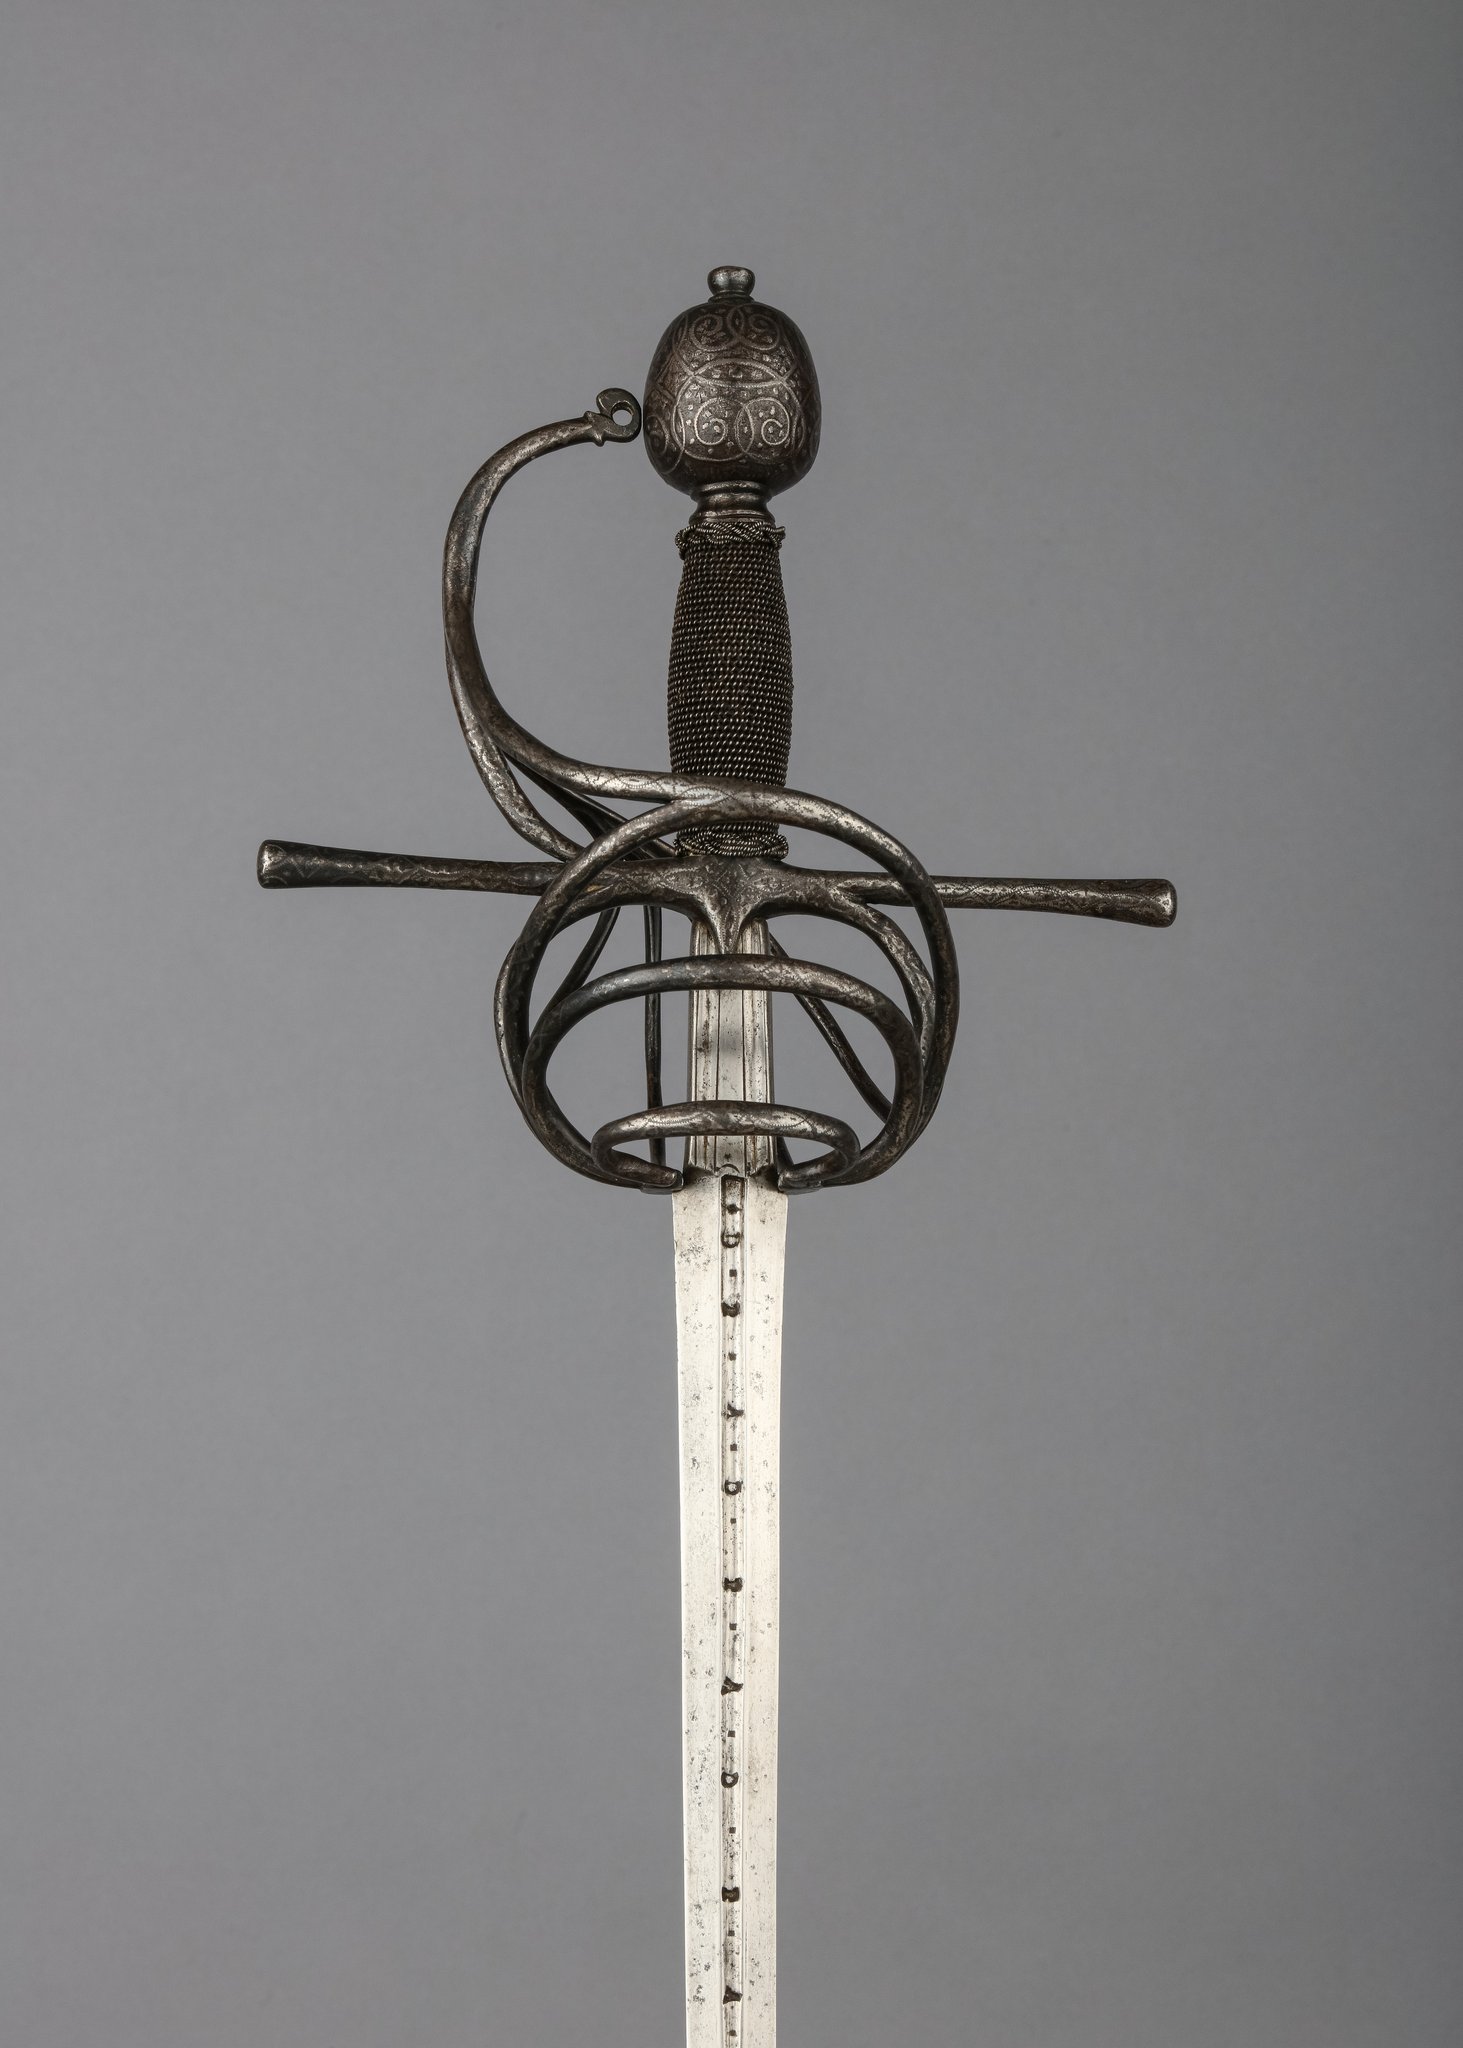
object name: rapier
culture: italian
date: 1567-1600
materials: steel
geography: italy